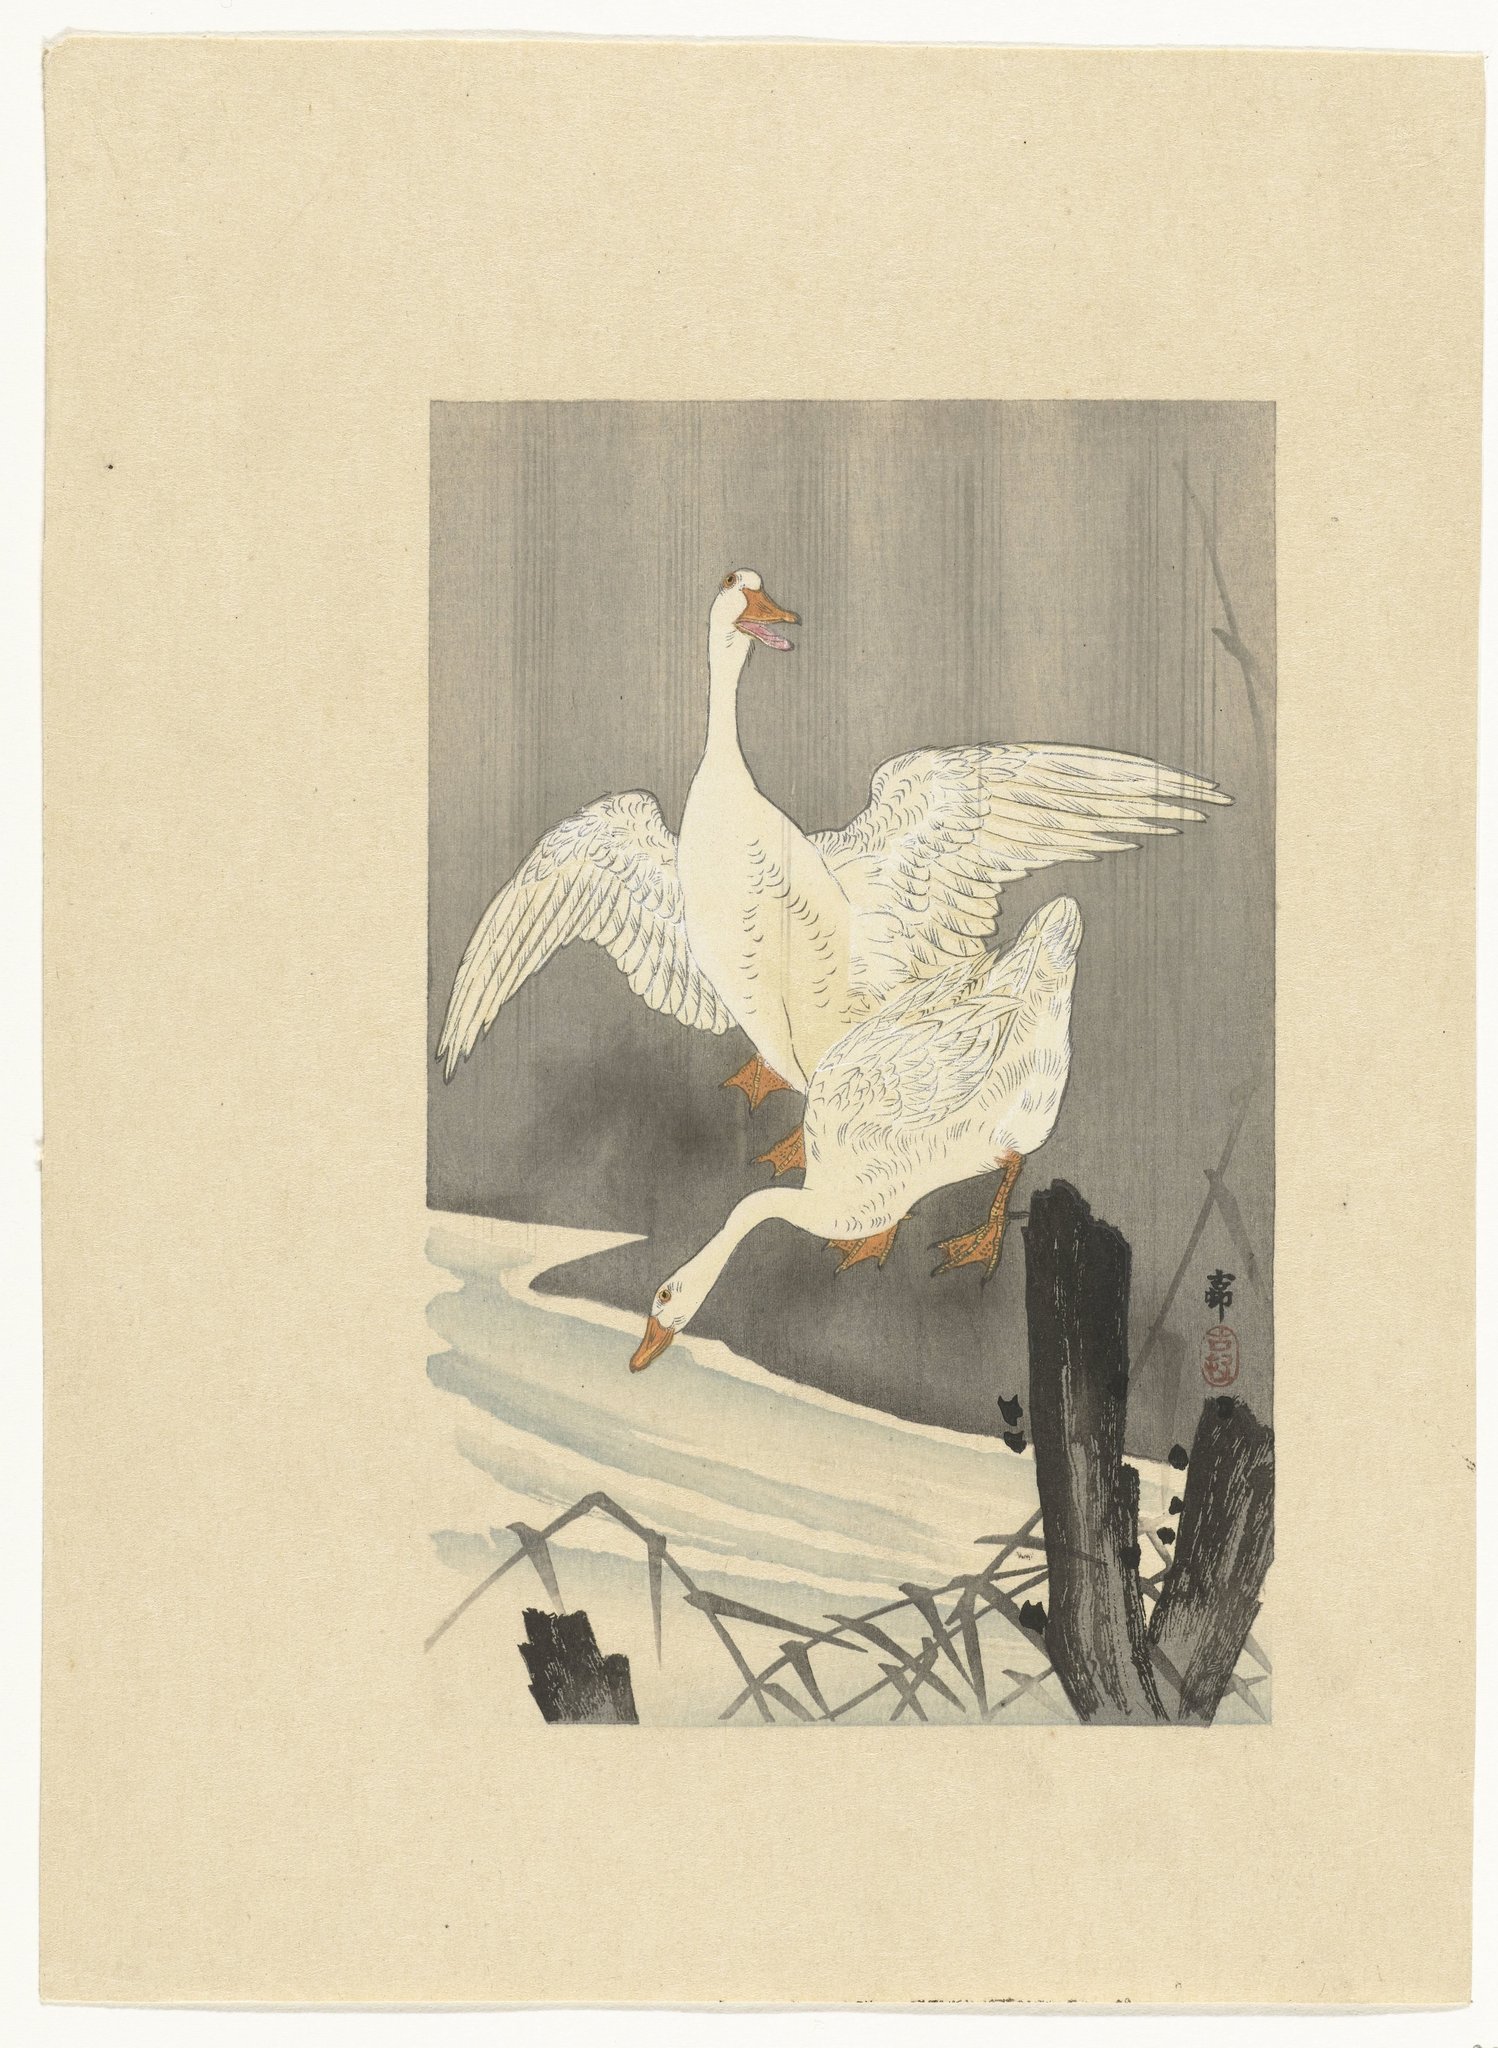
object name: print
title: Twee ganzen aan een rivier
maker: ohara koson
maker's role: print maker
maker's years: 1877-1945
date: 1900-1930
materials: paper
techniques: blind stamped, woodcut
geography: tokyo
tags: water-birds: goose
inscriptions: collector's mark: Lugt 2228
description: Twee ganzen aan een rivier. De een drinkt uit het water.